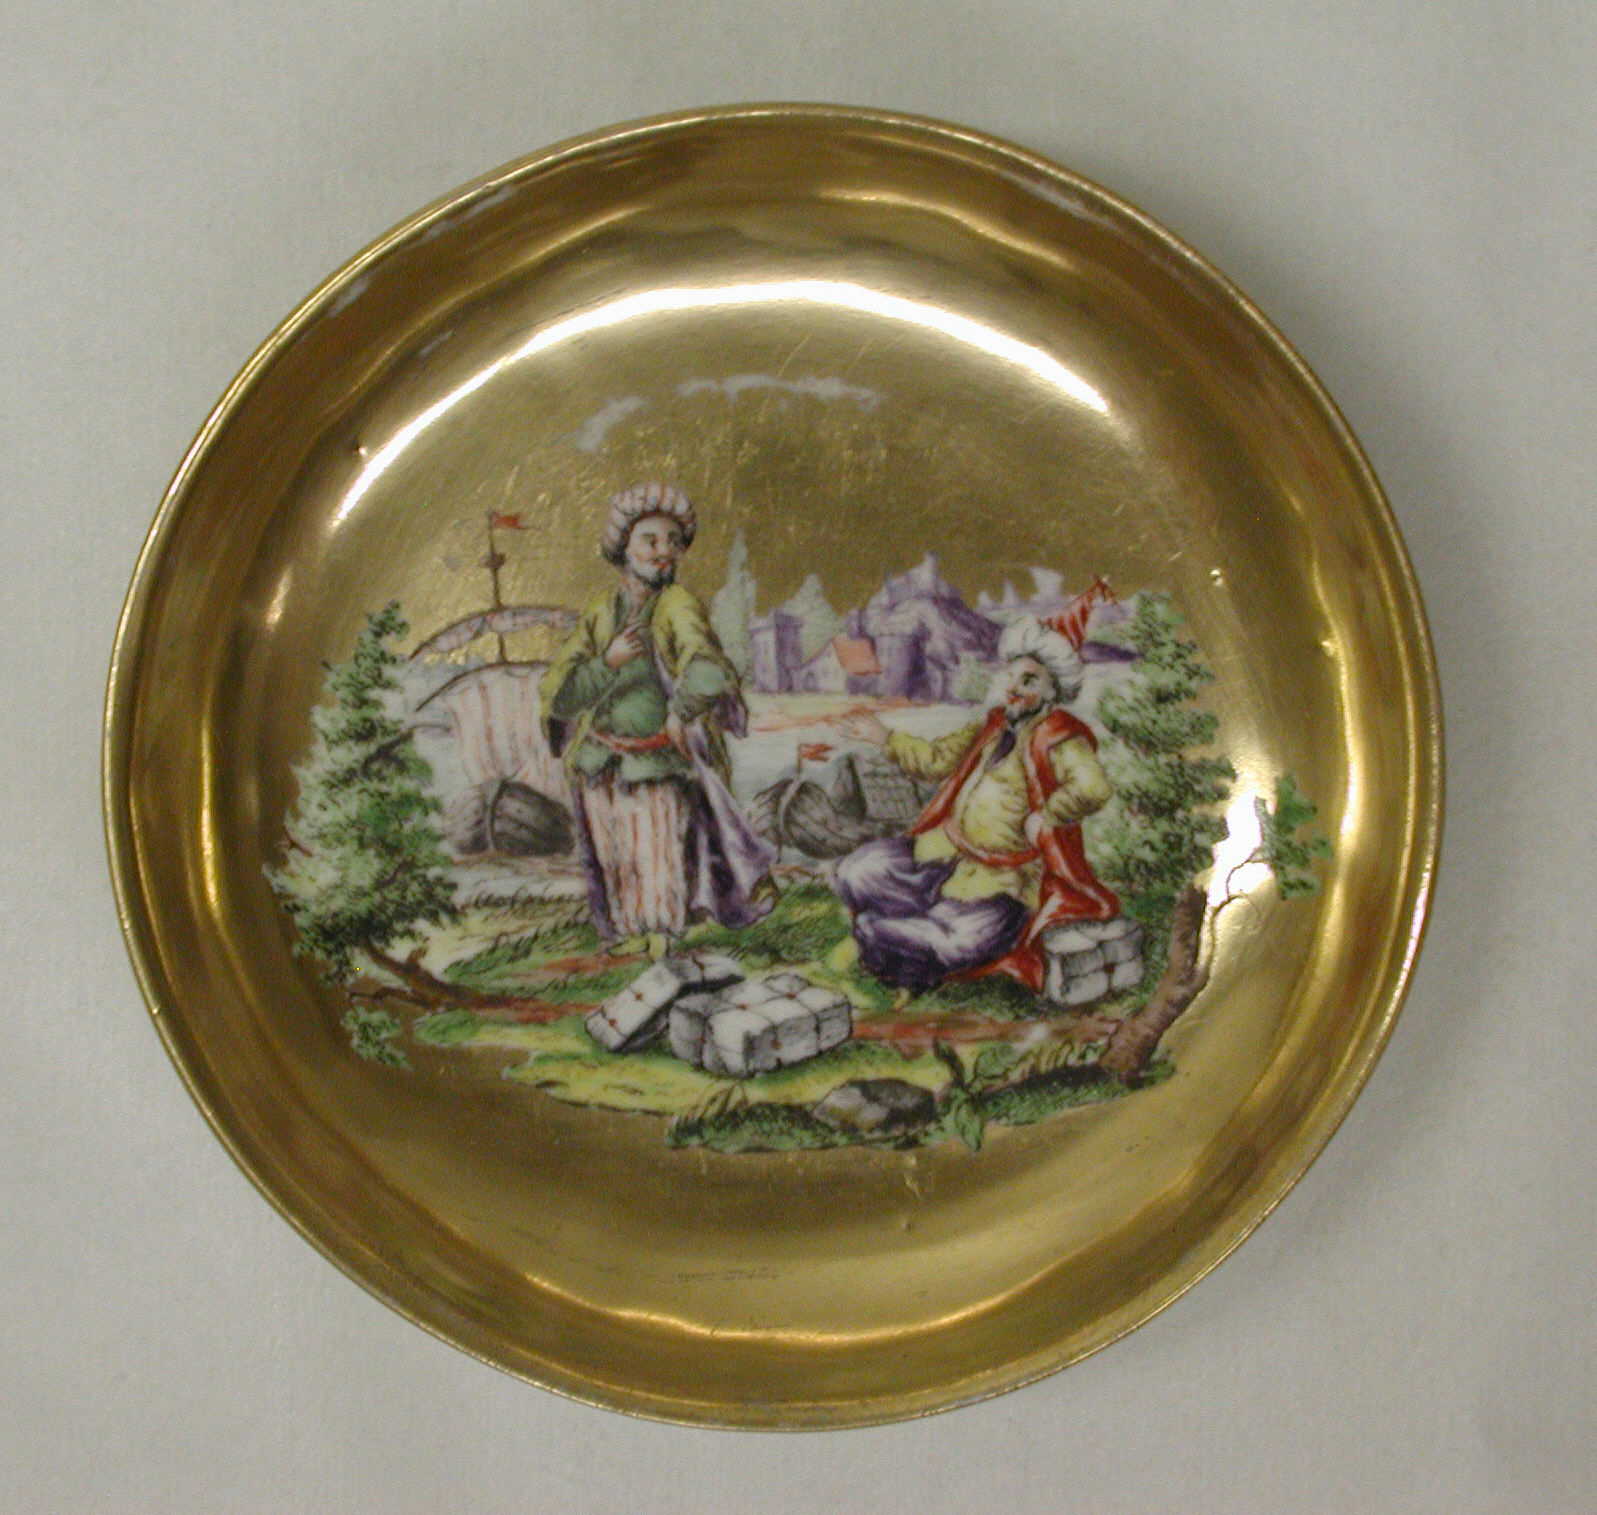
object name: saucer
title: Saucer (part of a service)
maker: nymphenburg porcelain manufactory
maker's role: manufactory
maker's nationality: german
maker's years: 1747-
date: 1760-1765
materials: hard paste porcelain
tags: houses,men,trees